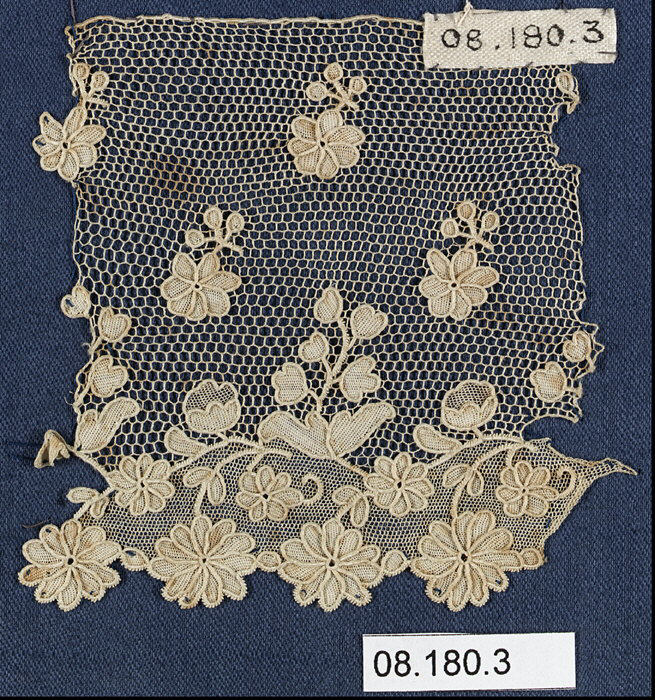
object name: fragment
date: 1801-1900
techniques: lace